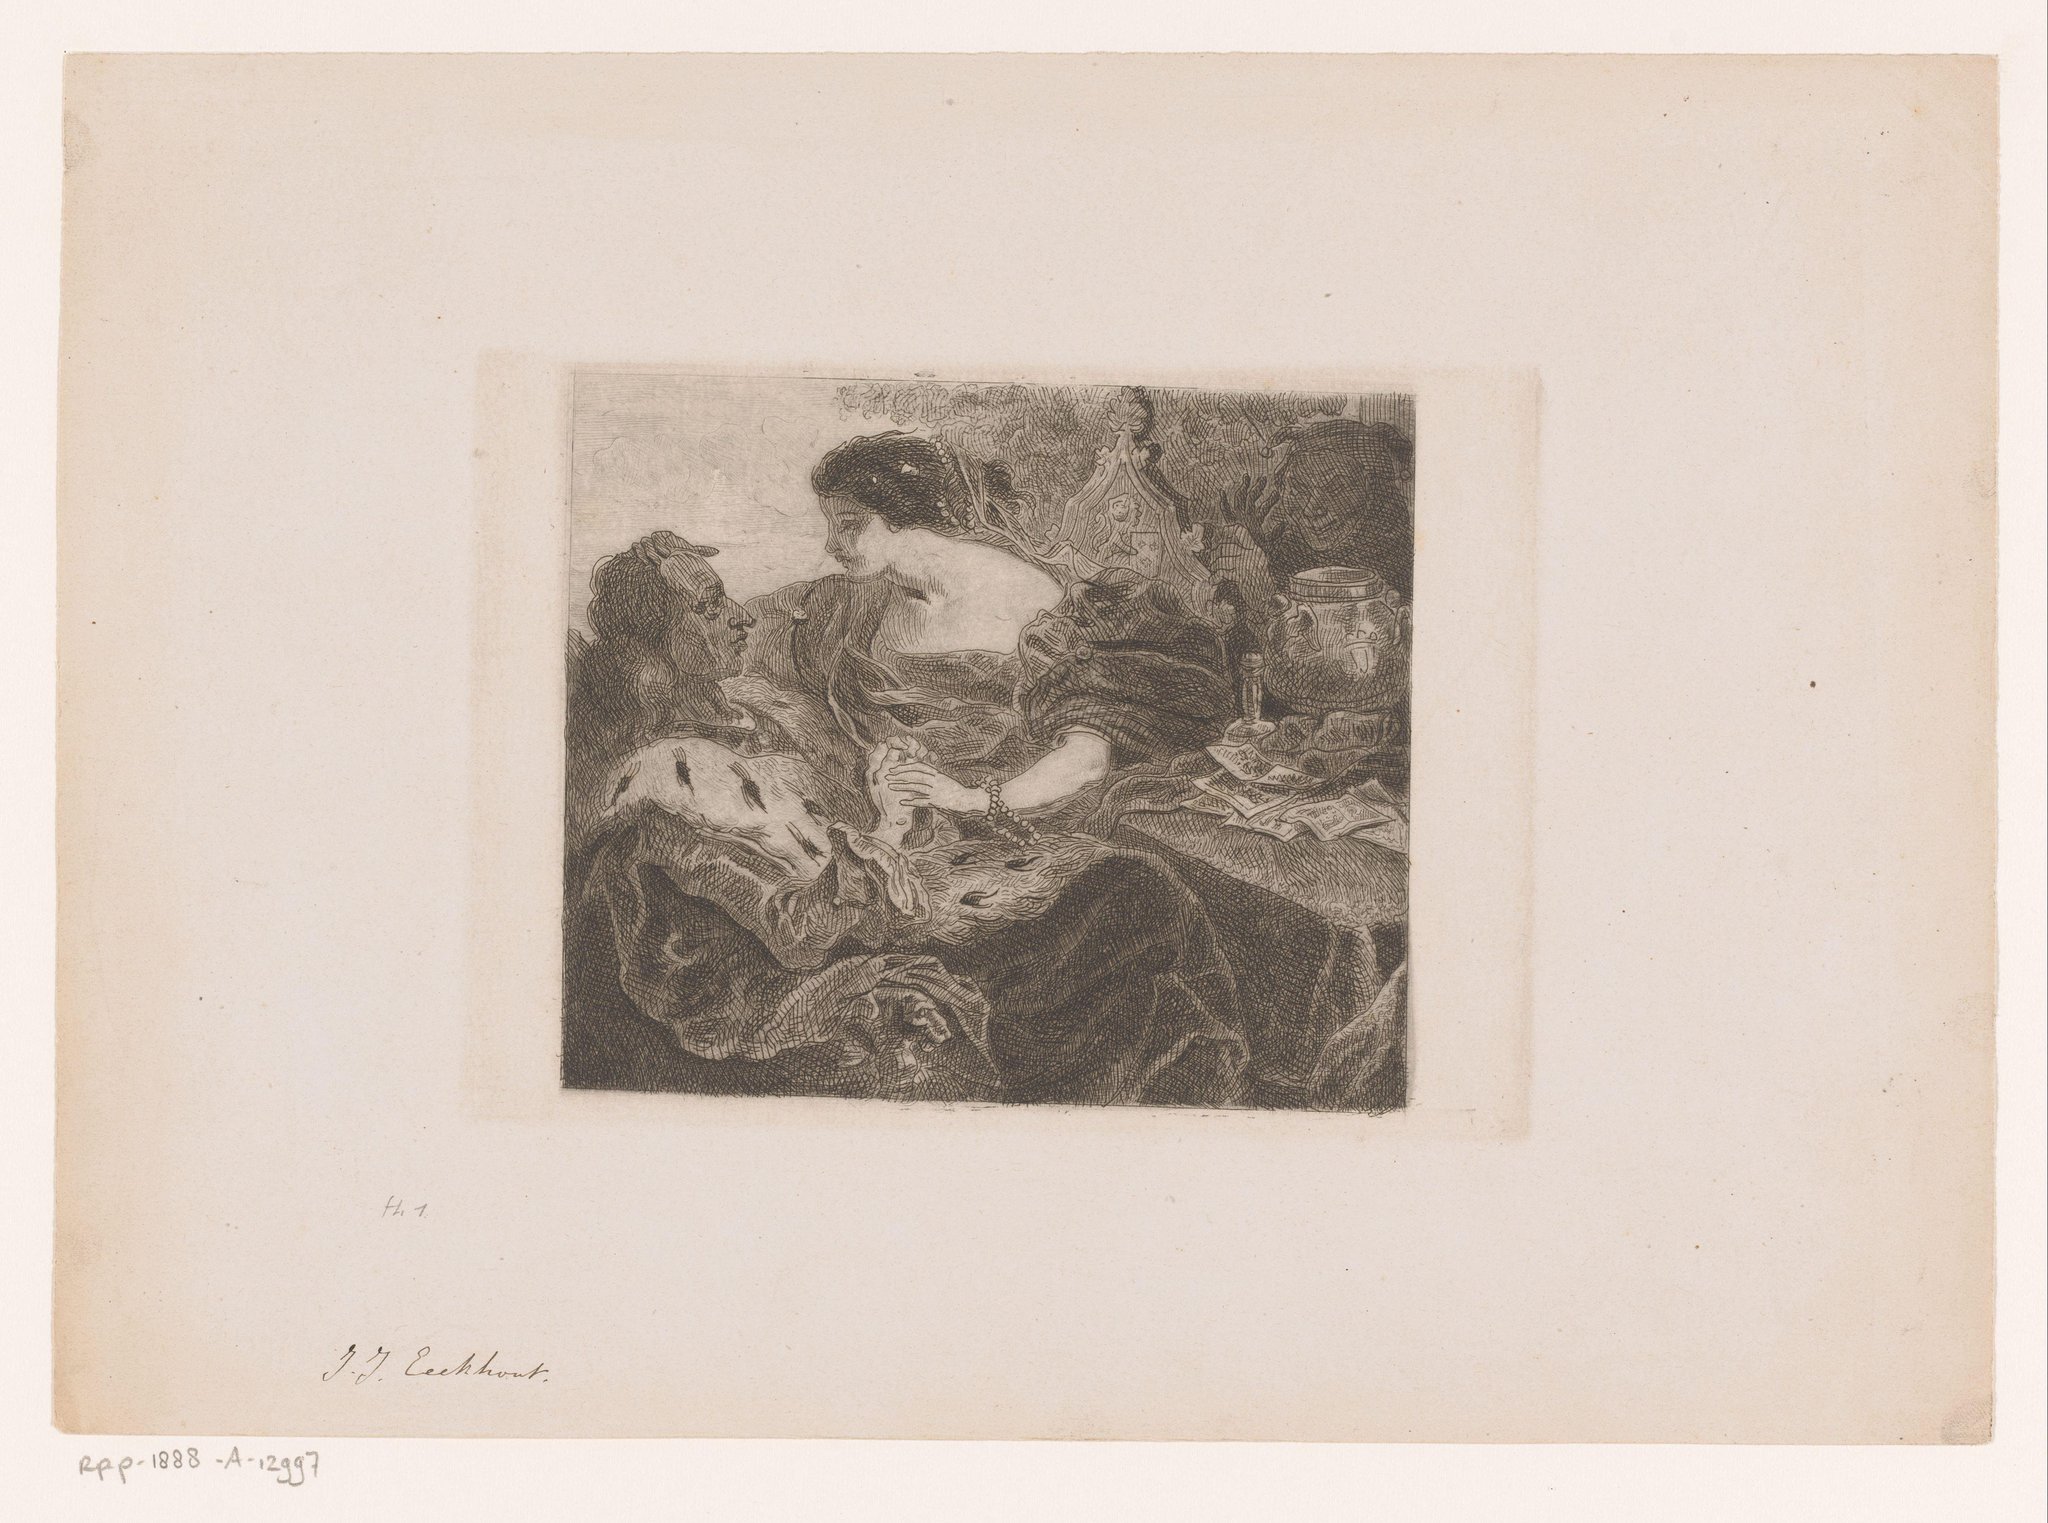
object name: print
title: Isabella aan tafel bij Karel VI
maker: jacob joseph eeckhout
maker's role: draughtsman, print maker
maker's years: 1793-1861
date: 1803-1861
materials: paper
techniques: drypoint, etching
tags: paris, queen, king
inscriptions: collector's mark: Lugt 2228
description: Koning Karel VI trouwde met Isabella van Beieren. De narrenfiguur in de achtergrond van deze prent symboliseert de waanbeelden die Karel VI teisterden.